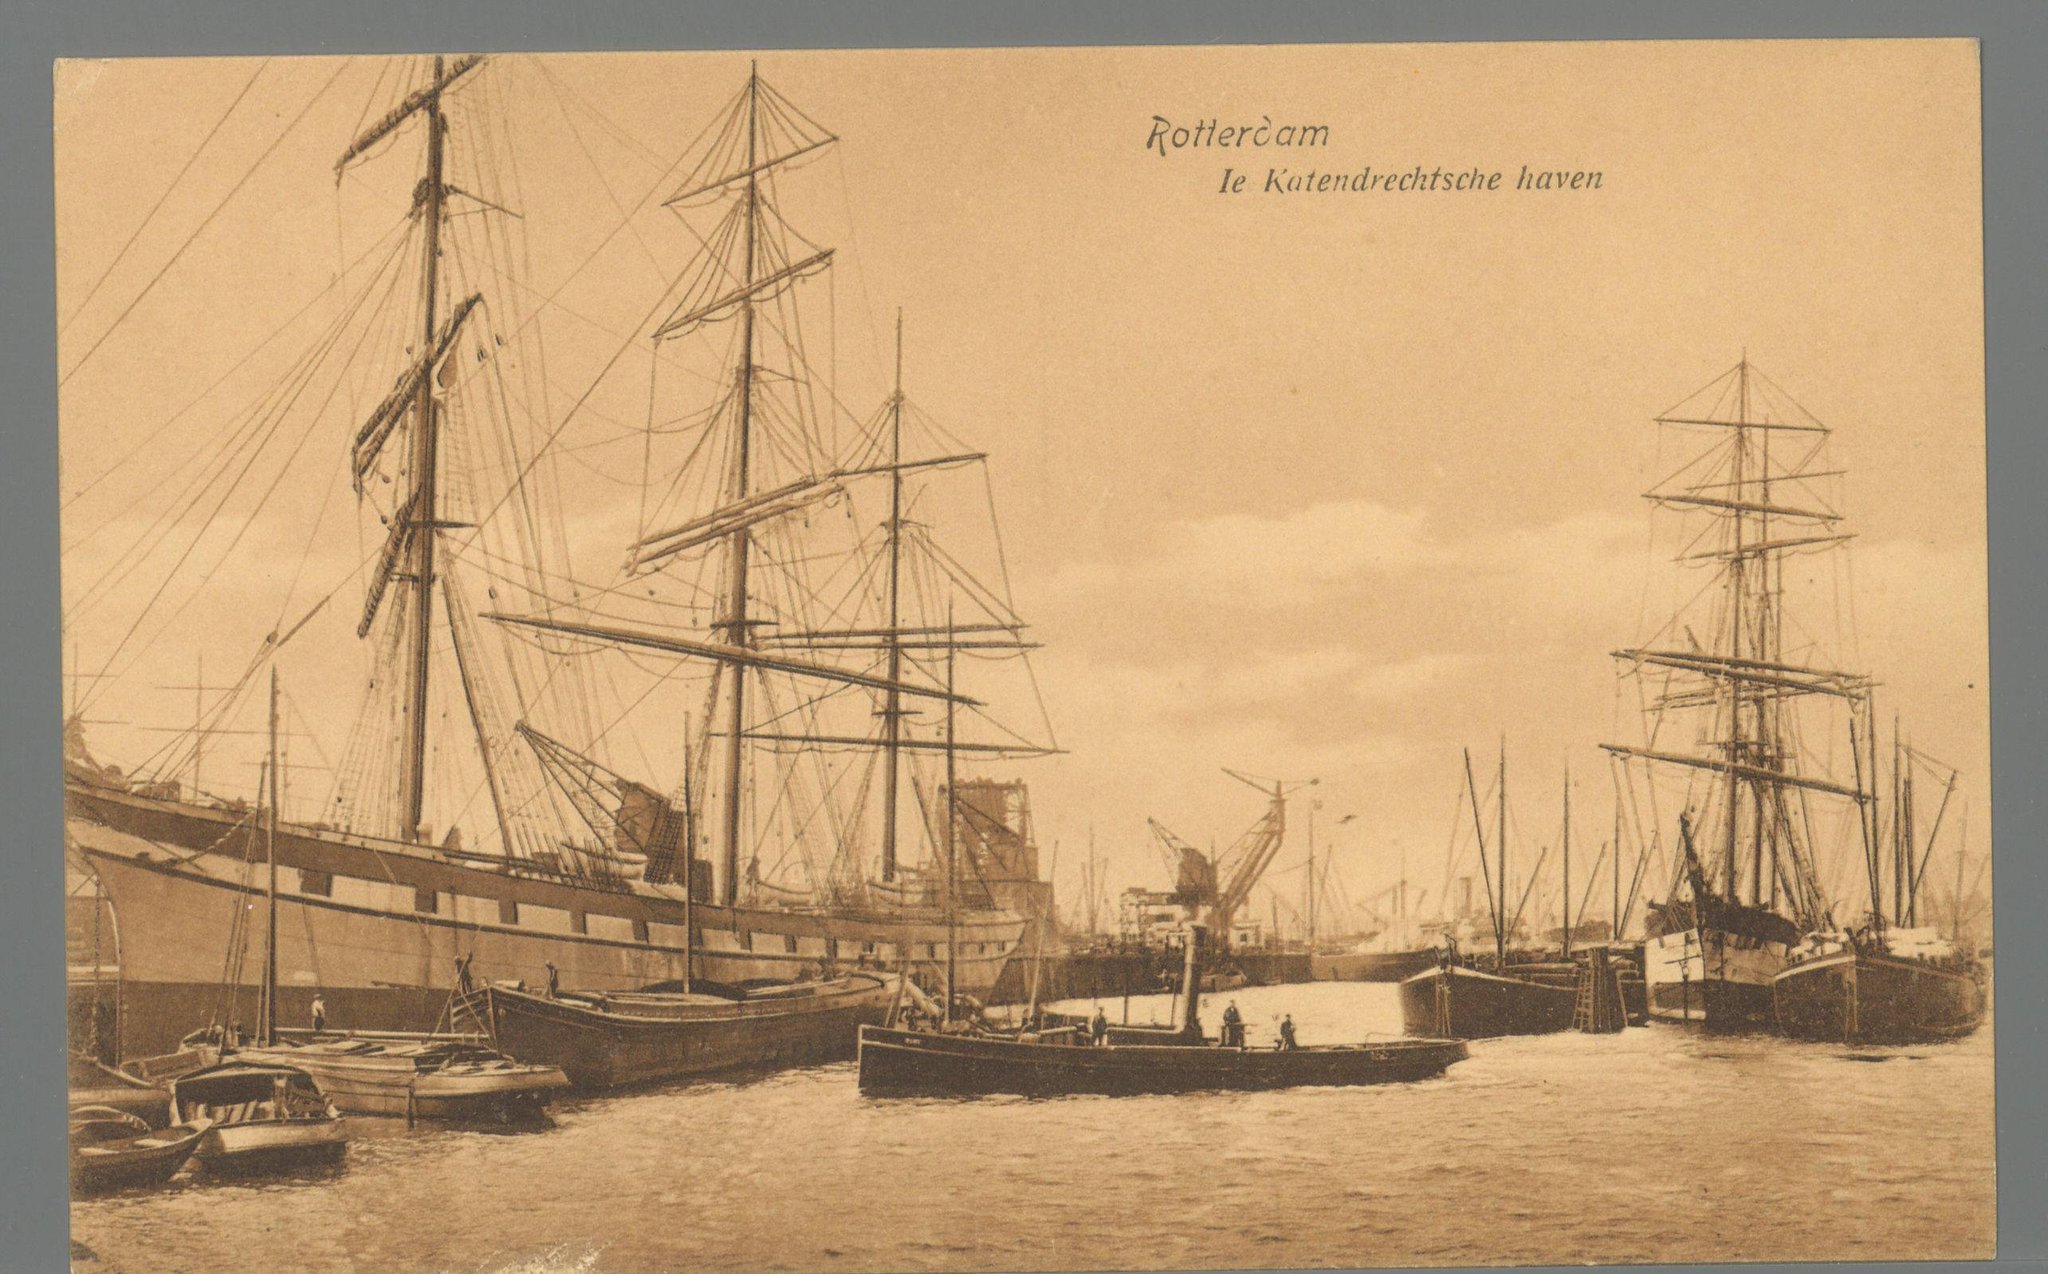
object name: ansichtkaart, prentbriefkaart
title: Rotterdam. Ie Katendrechtsche haven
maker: Anonymous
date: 1911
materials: cardboard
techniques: photograph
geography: the hague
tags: harbour, ships (in general), rotterdam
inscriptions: date